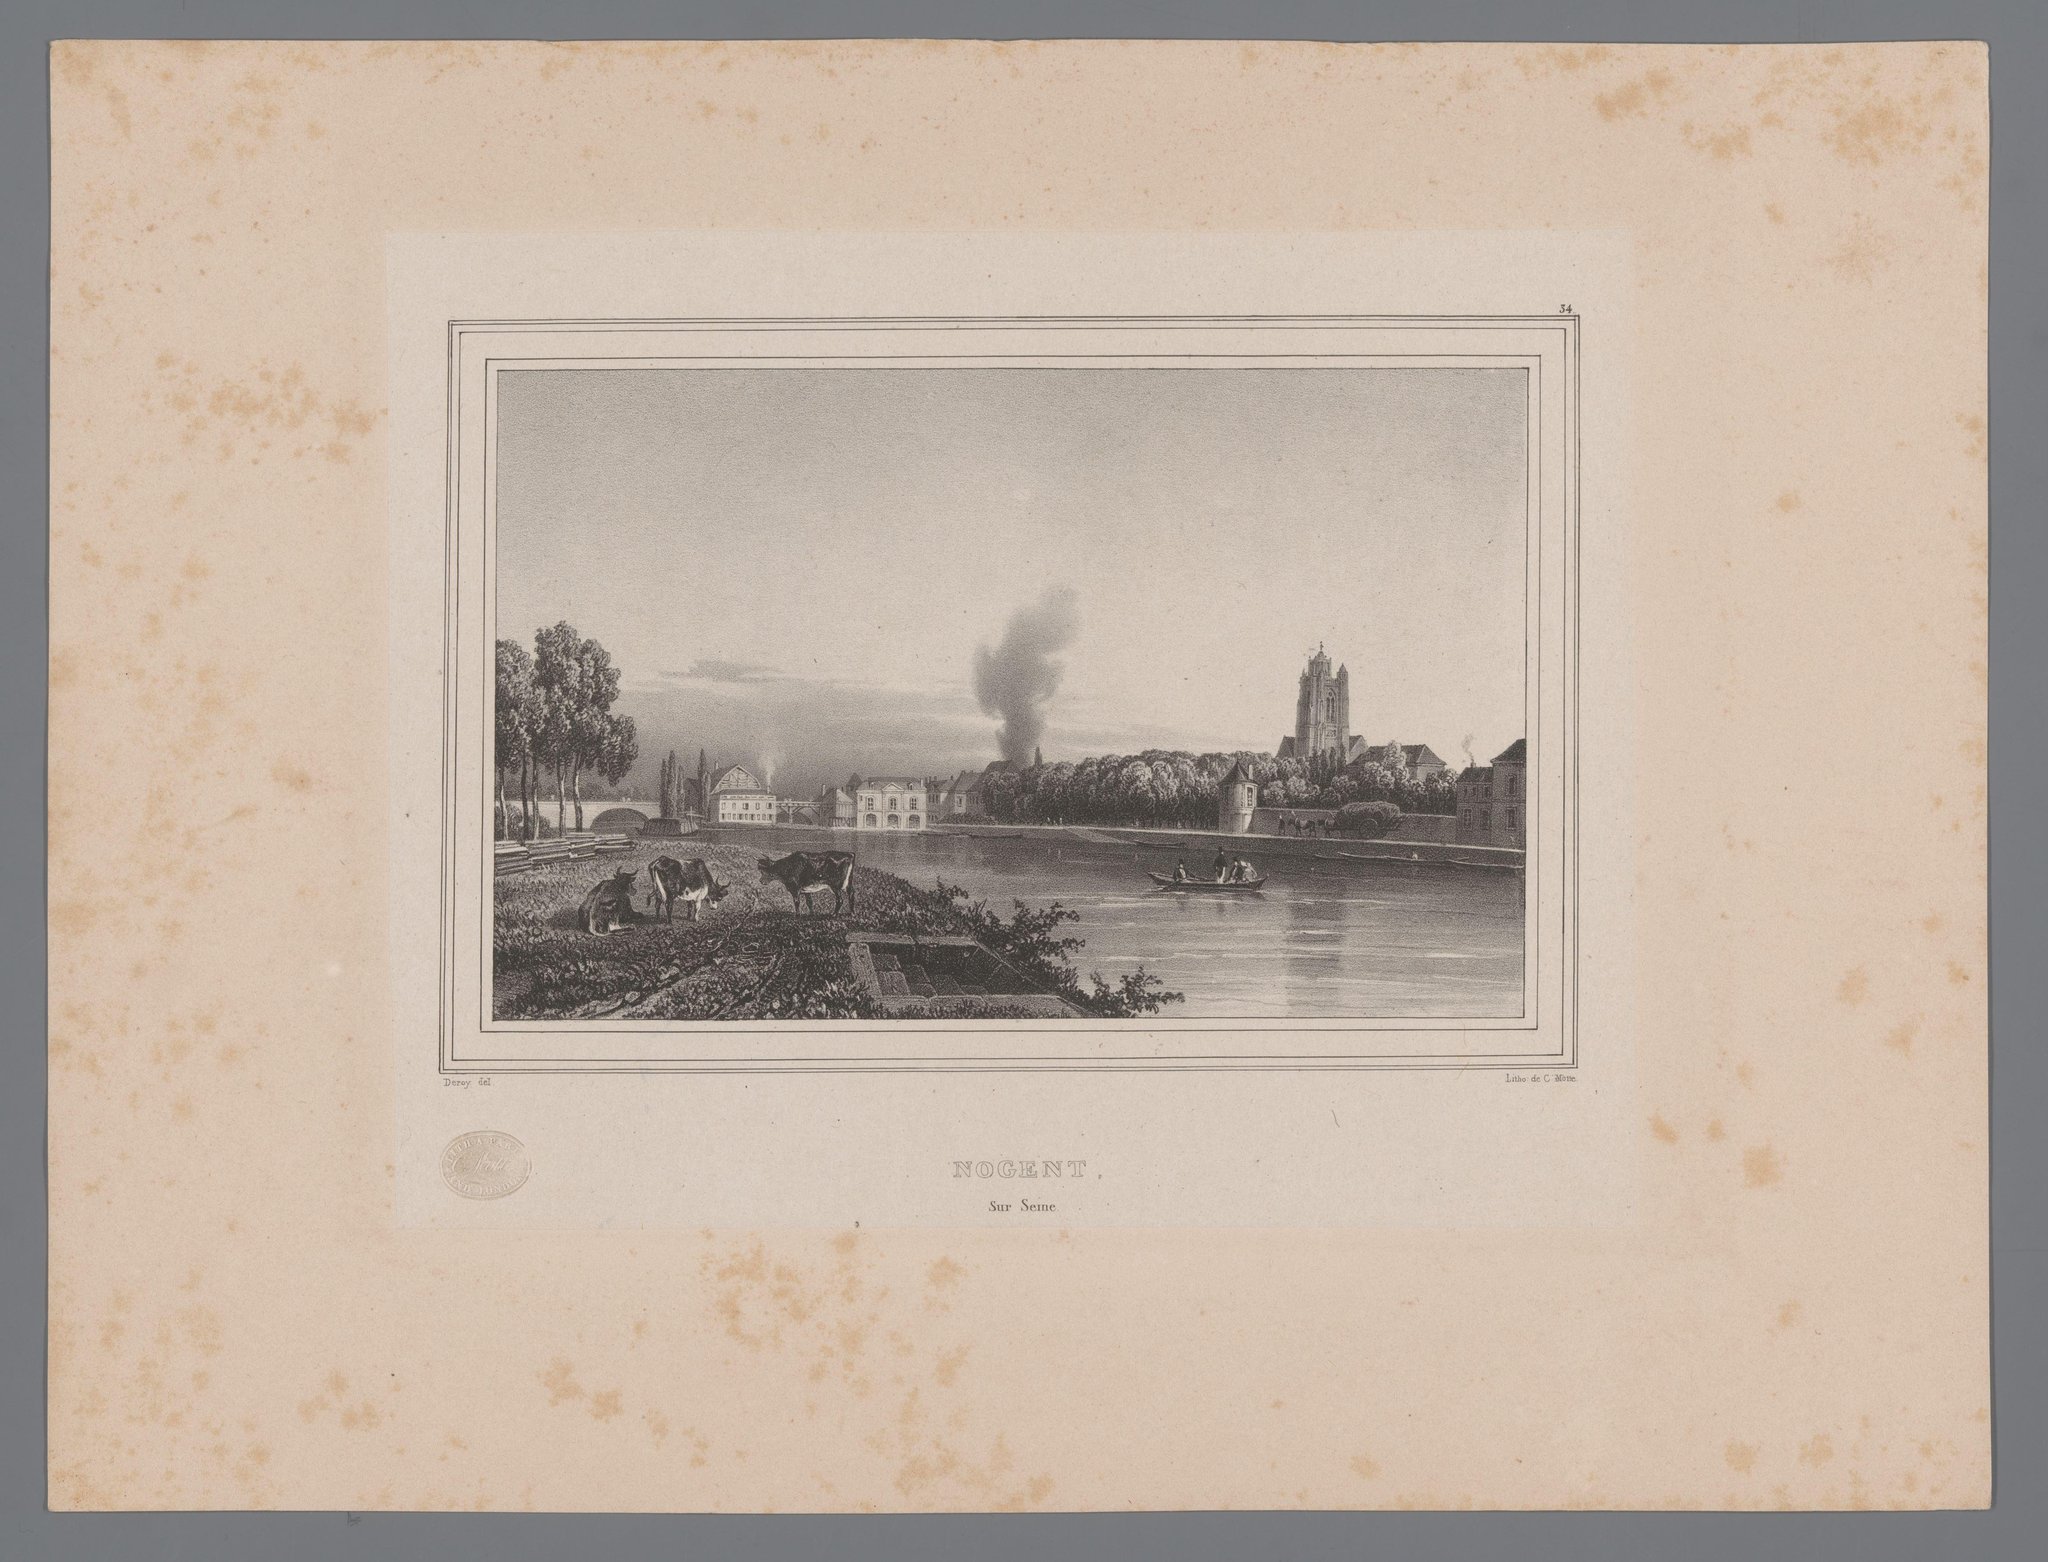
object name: print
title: Zicht op Nogent-sur-Seine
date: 1829-1831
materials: paper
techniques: lithograph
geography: paris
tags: river (+ landscape with figures, staffage), prospect of city, town panorama, silhouette of city (+ city(-scape) with figures, staffage)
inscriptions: collector's mark: Lugt 2228a, check stamp: Lugt 1828b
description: Prent maakt deel uit van een omslag met dertien prenten.